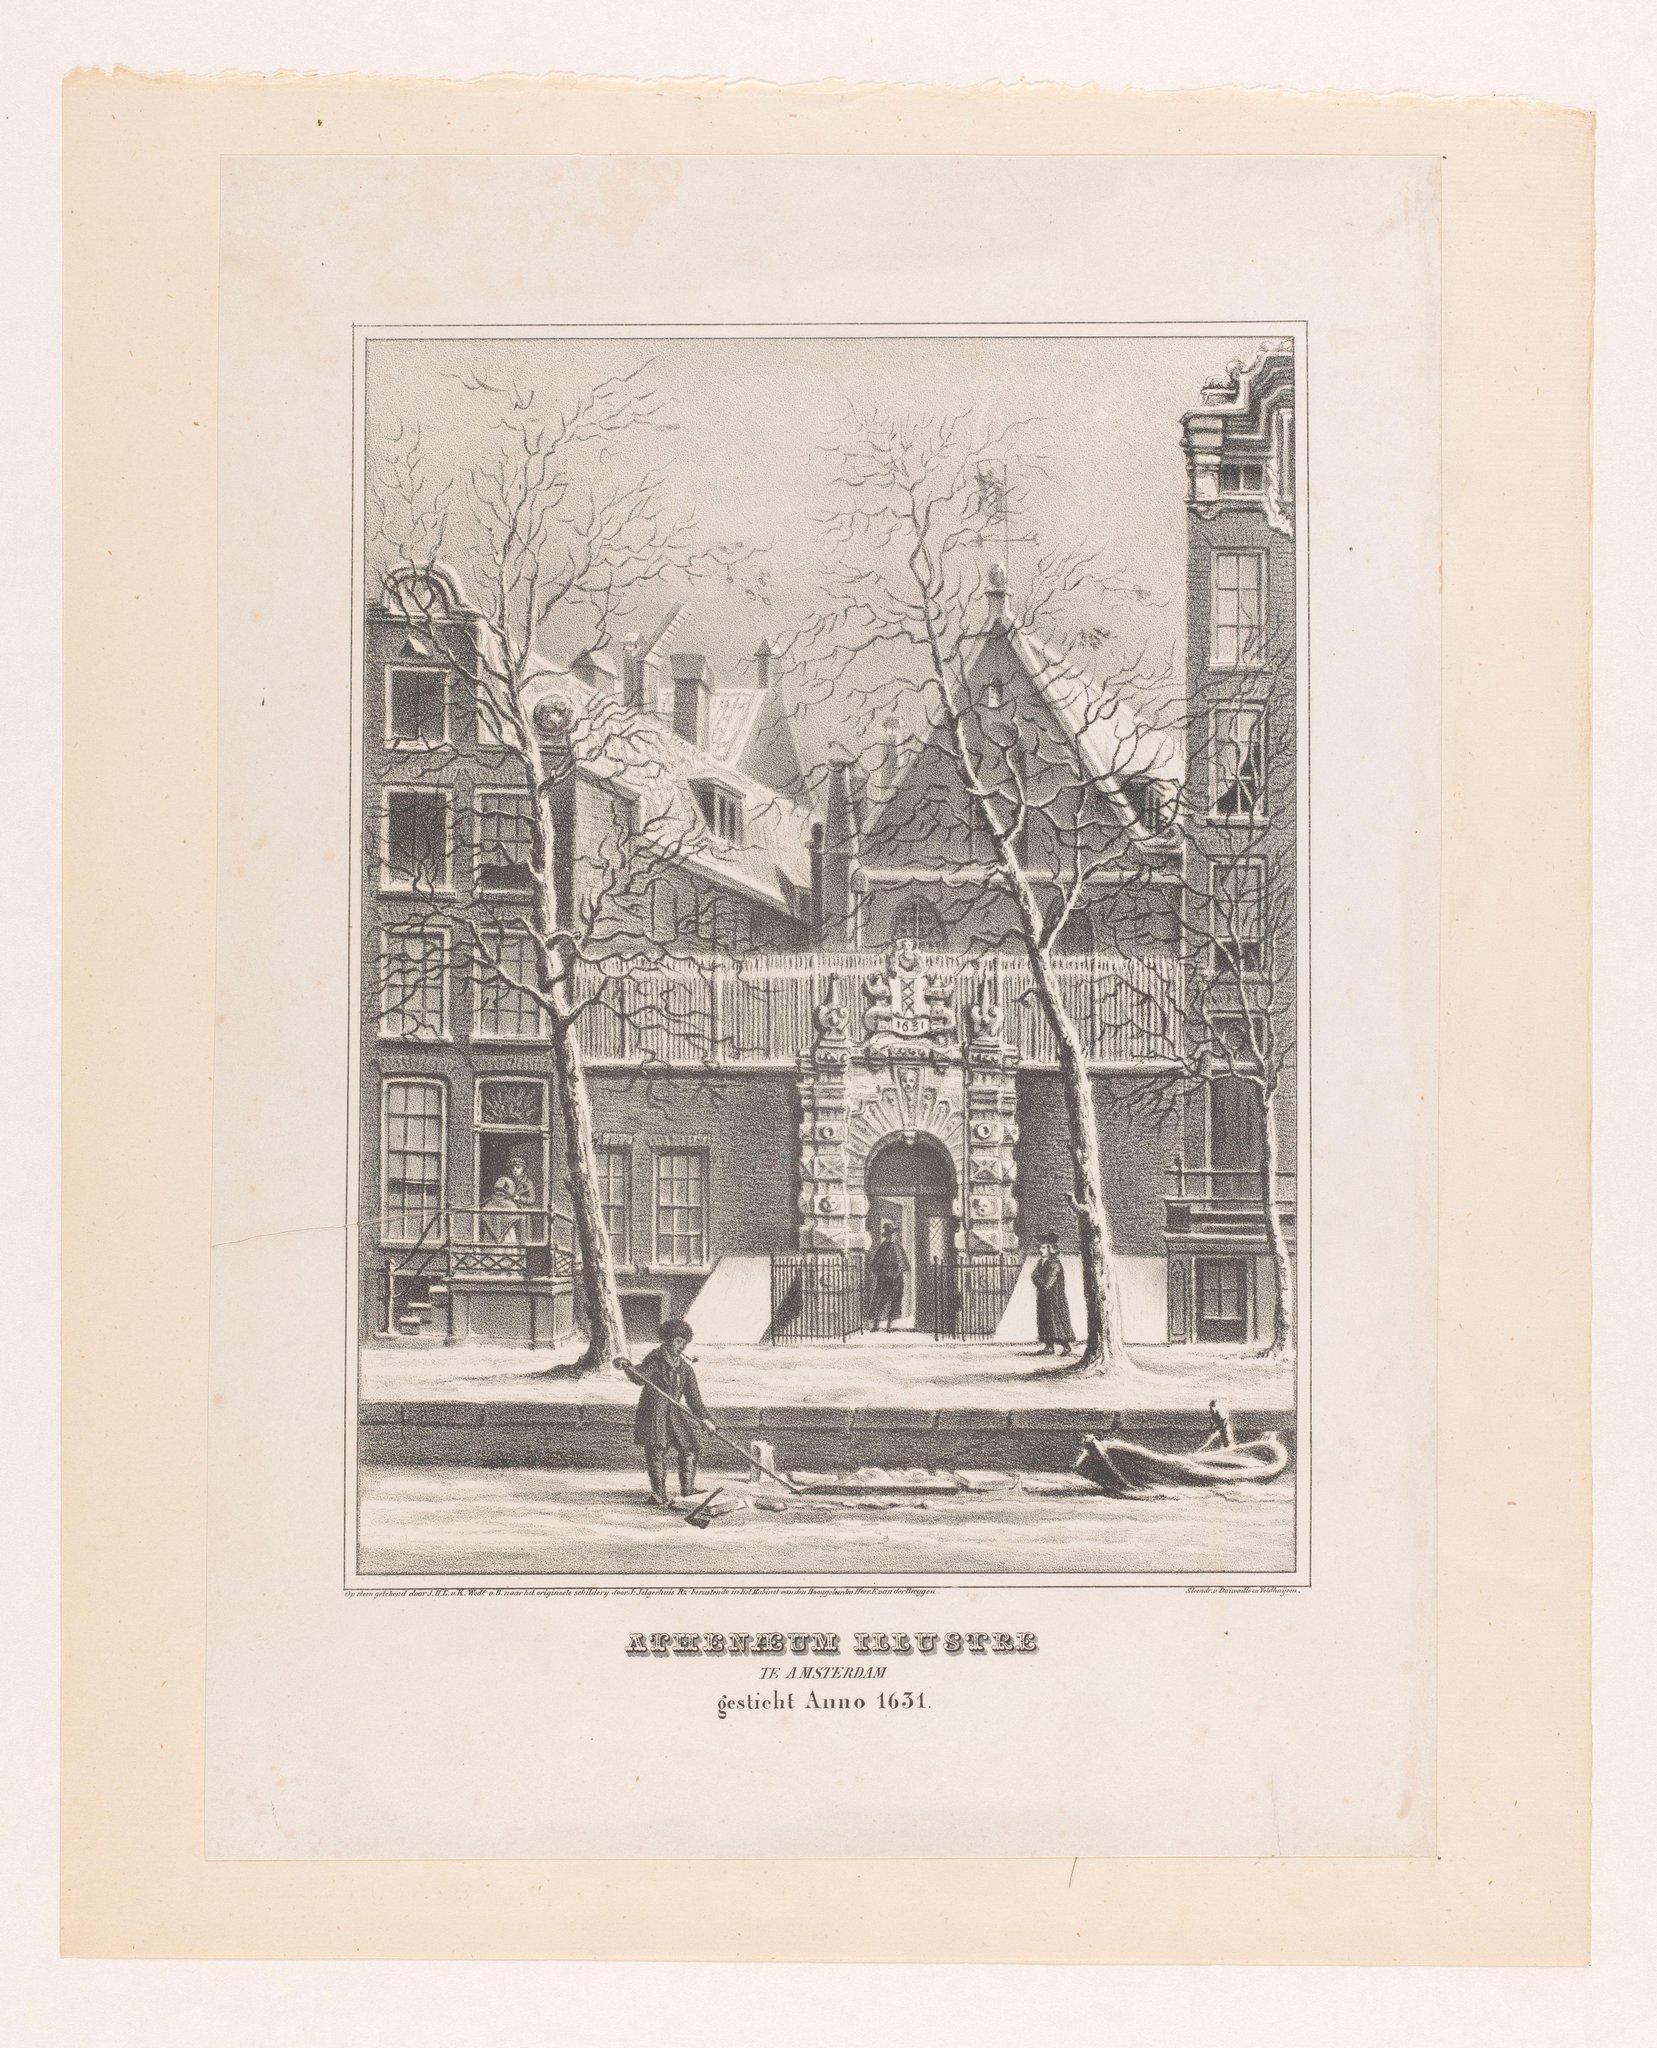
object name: print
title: Gezicht op het Athenaeum Illustre te Amsterdam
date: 1831-1832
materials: paper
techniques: lithograph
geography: amsterdam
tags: gate, entrance, ice ~ freezing weather, canals, waters (in city)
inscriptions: collector's mark: Lugt 2760, collector's mark: Lugt 2228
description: De gracht voor het gebouw is bevroren. Een figuur staat op het ijs. Op straat lopen figuren.